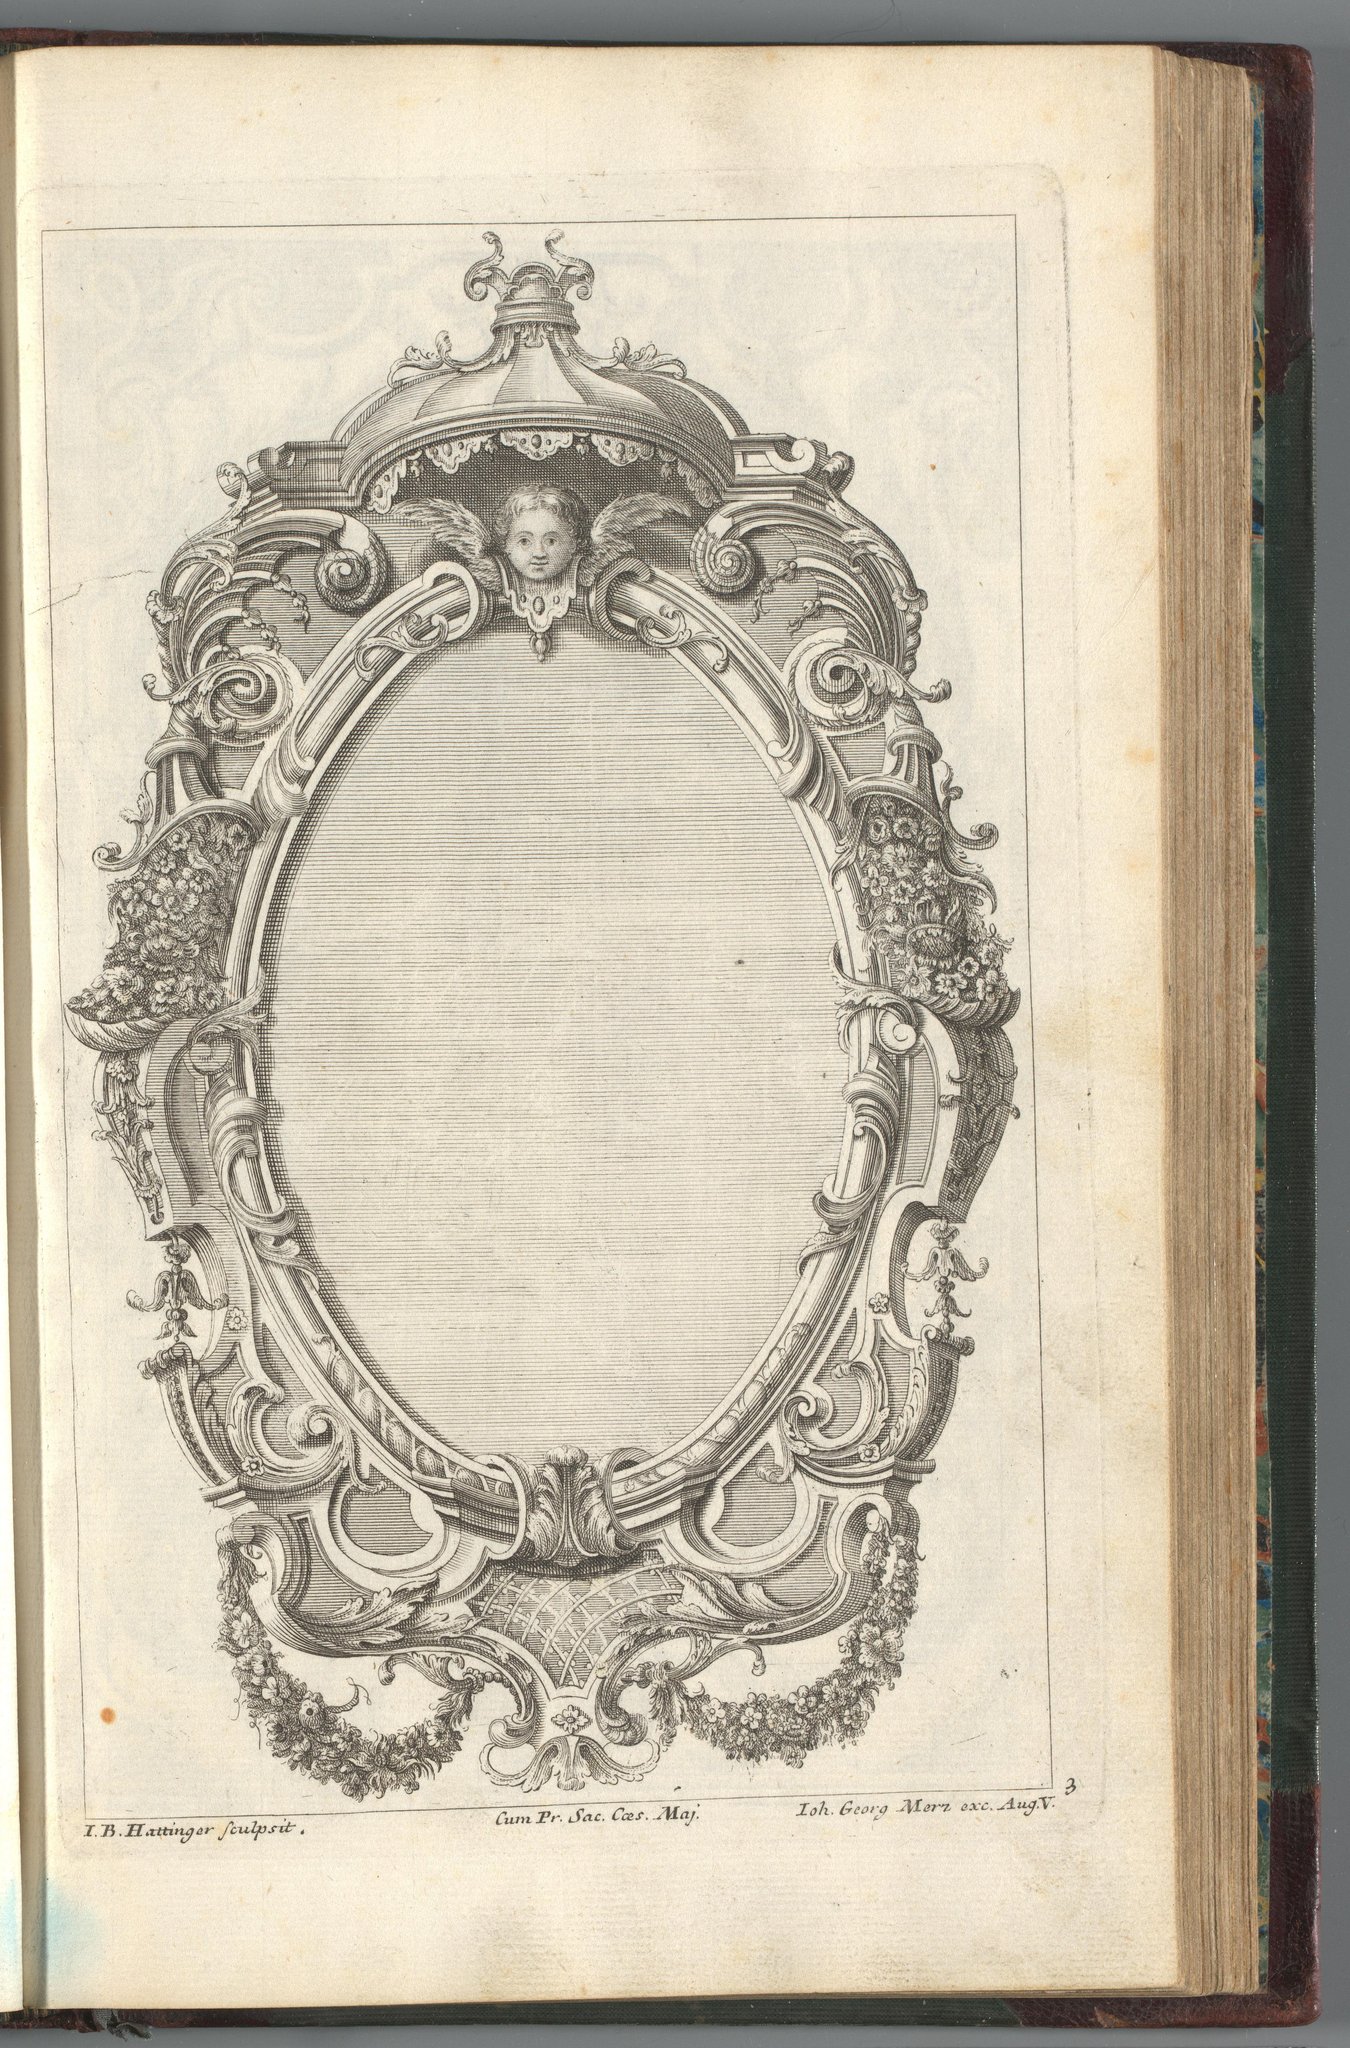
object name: print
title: Spiegel ontwerp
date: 1704-1762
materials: paper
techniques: engraving, etching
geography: augsburg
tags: ornaments ~ art, rocaille ornament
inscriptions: signature: ‘Joh Georg Merz exc. Aug V.’, privilege: ‘Cum Pr. Sac. Cas. Maj.’, number: ‘3’, signature: ‘J. B. Hattinger sculpsit’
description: Ontwerp voor een ovale spiegel met rocaille ornamenten, bloemen en een engelen kopje. Prent maakt deel uit van een album.